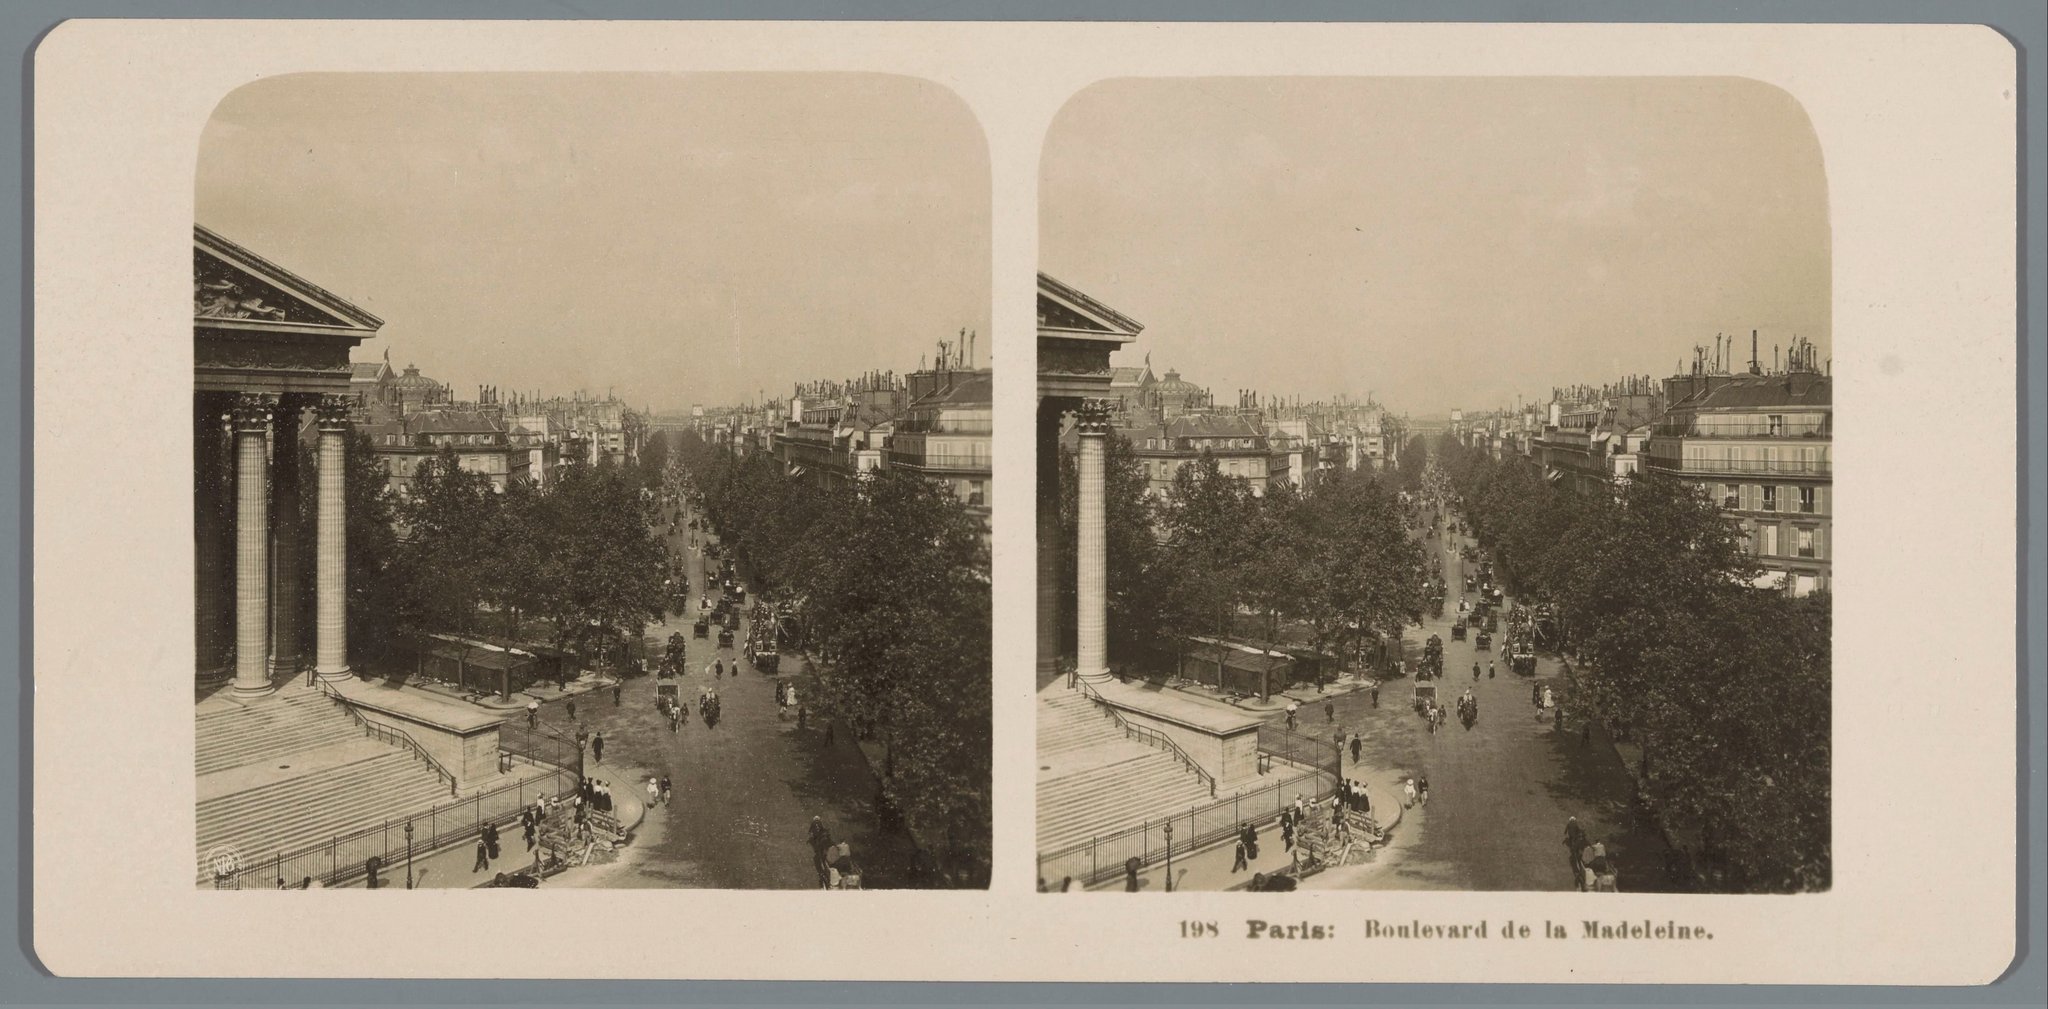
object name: stereograph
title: Paris: Boulevard de la Madeleine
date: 1895-1905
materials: cardboard, photographic support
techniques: gelatin silver print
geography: paris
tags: four-wheeled, animal-drawn vehicle, e.g.: cab, carriage, coach, avenue, boulevard, promenade, esplanade, façade (of house or building)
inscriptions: inscription: ‘NPG’, number: ‘198’